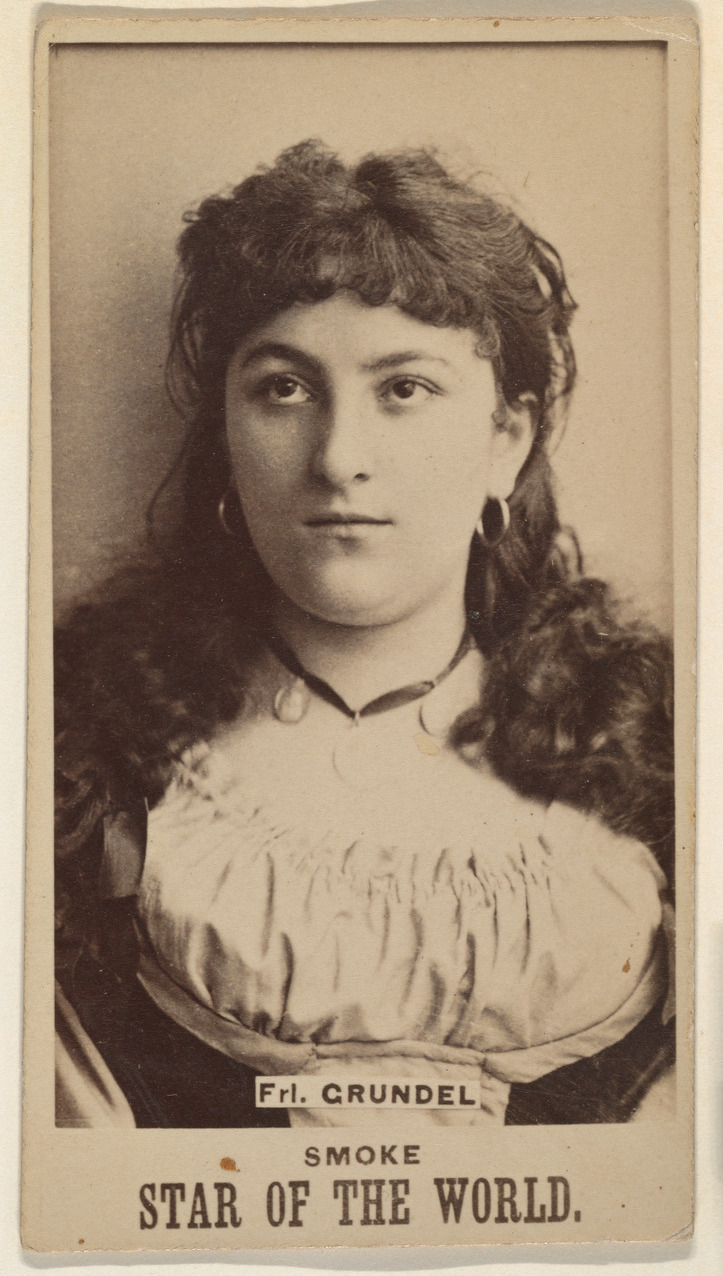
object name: photograph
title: Fraulein Grundel, from the Star of the World series (N672), issued by A. Hershey & Bros. to promote Star of the World Tobacco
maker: a. hershey & bros.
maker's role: publisher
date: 1888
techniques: albumen silver print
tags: portraits,women,actresses